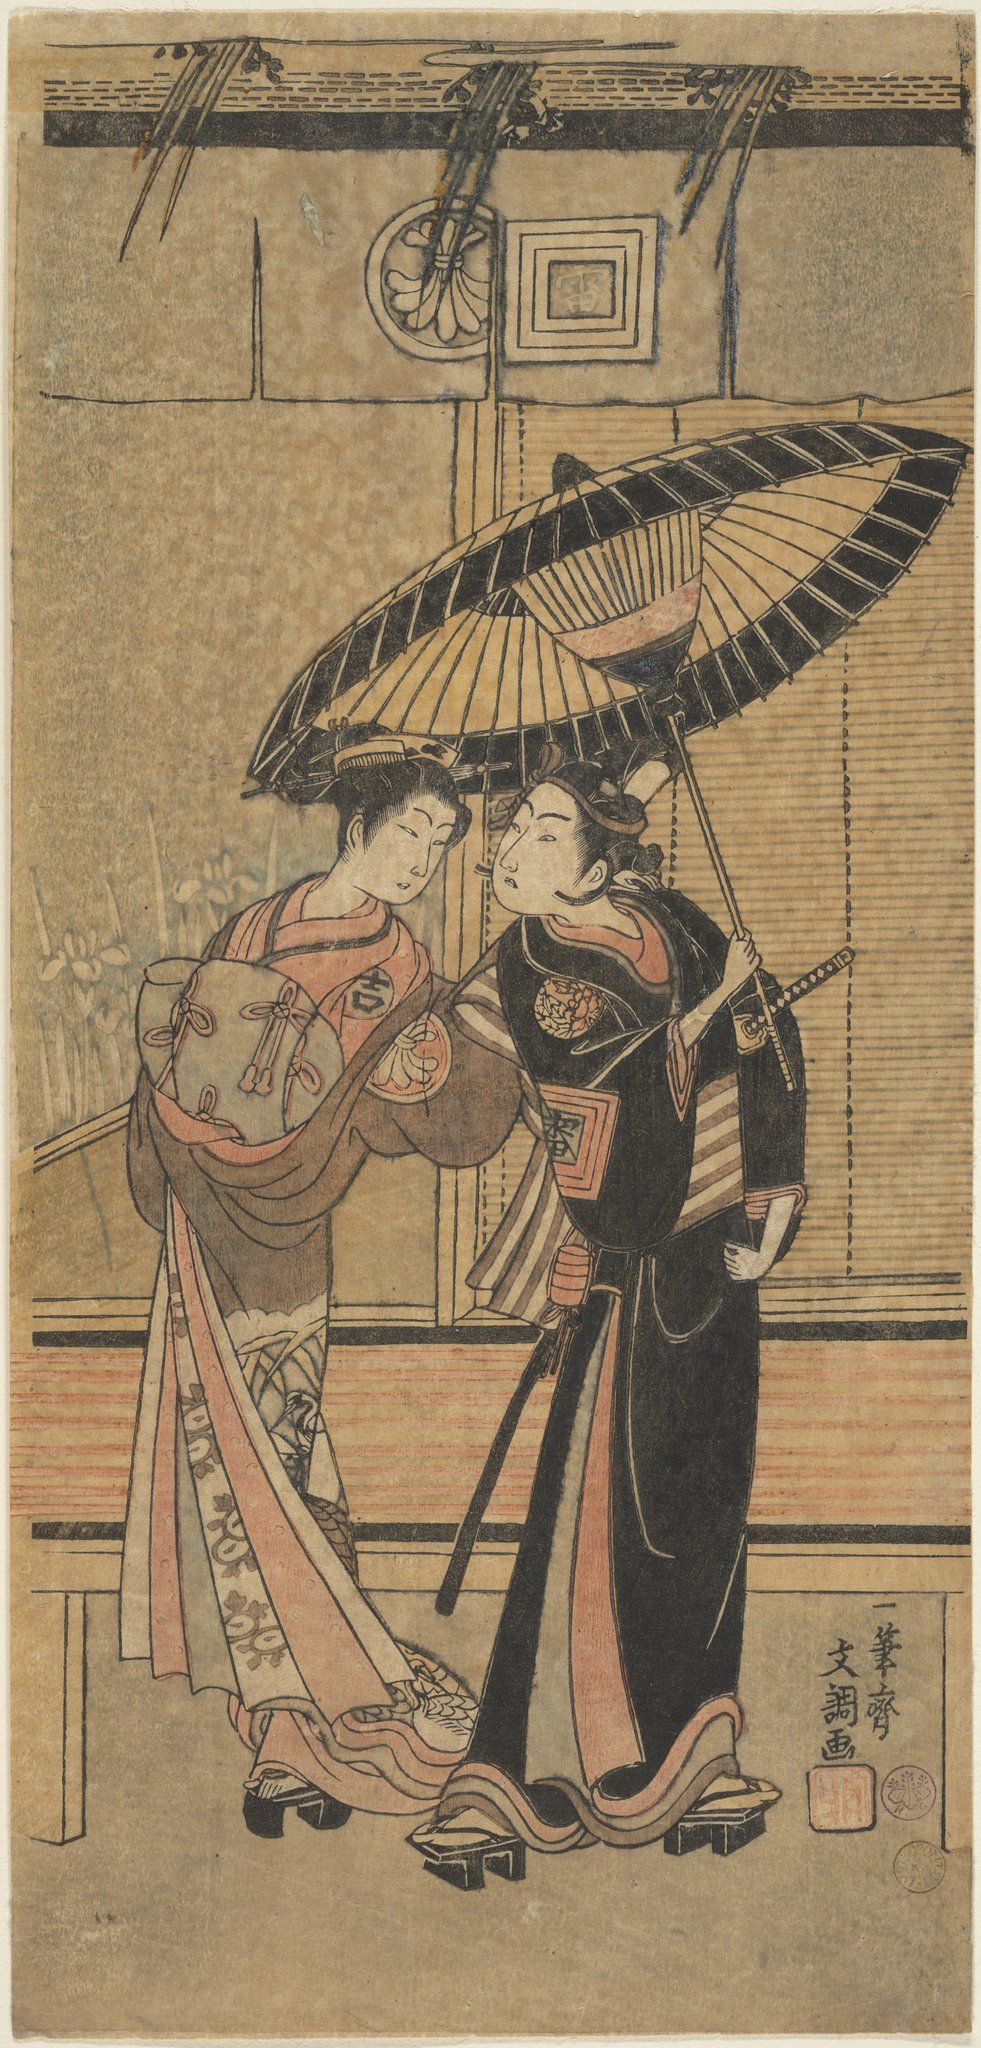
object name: print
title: Segawa Kikunojo II as a Girl and Ichikawa Tomiyeimon?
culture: japanese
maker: ippitsusai bunchō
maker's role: artist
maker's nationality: japanese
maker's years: 1765-1792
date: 1770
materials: ink, paper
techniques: woodblock print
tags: girls,men,actors